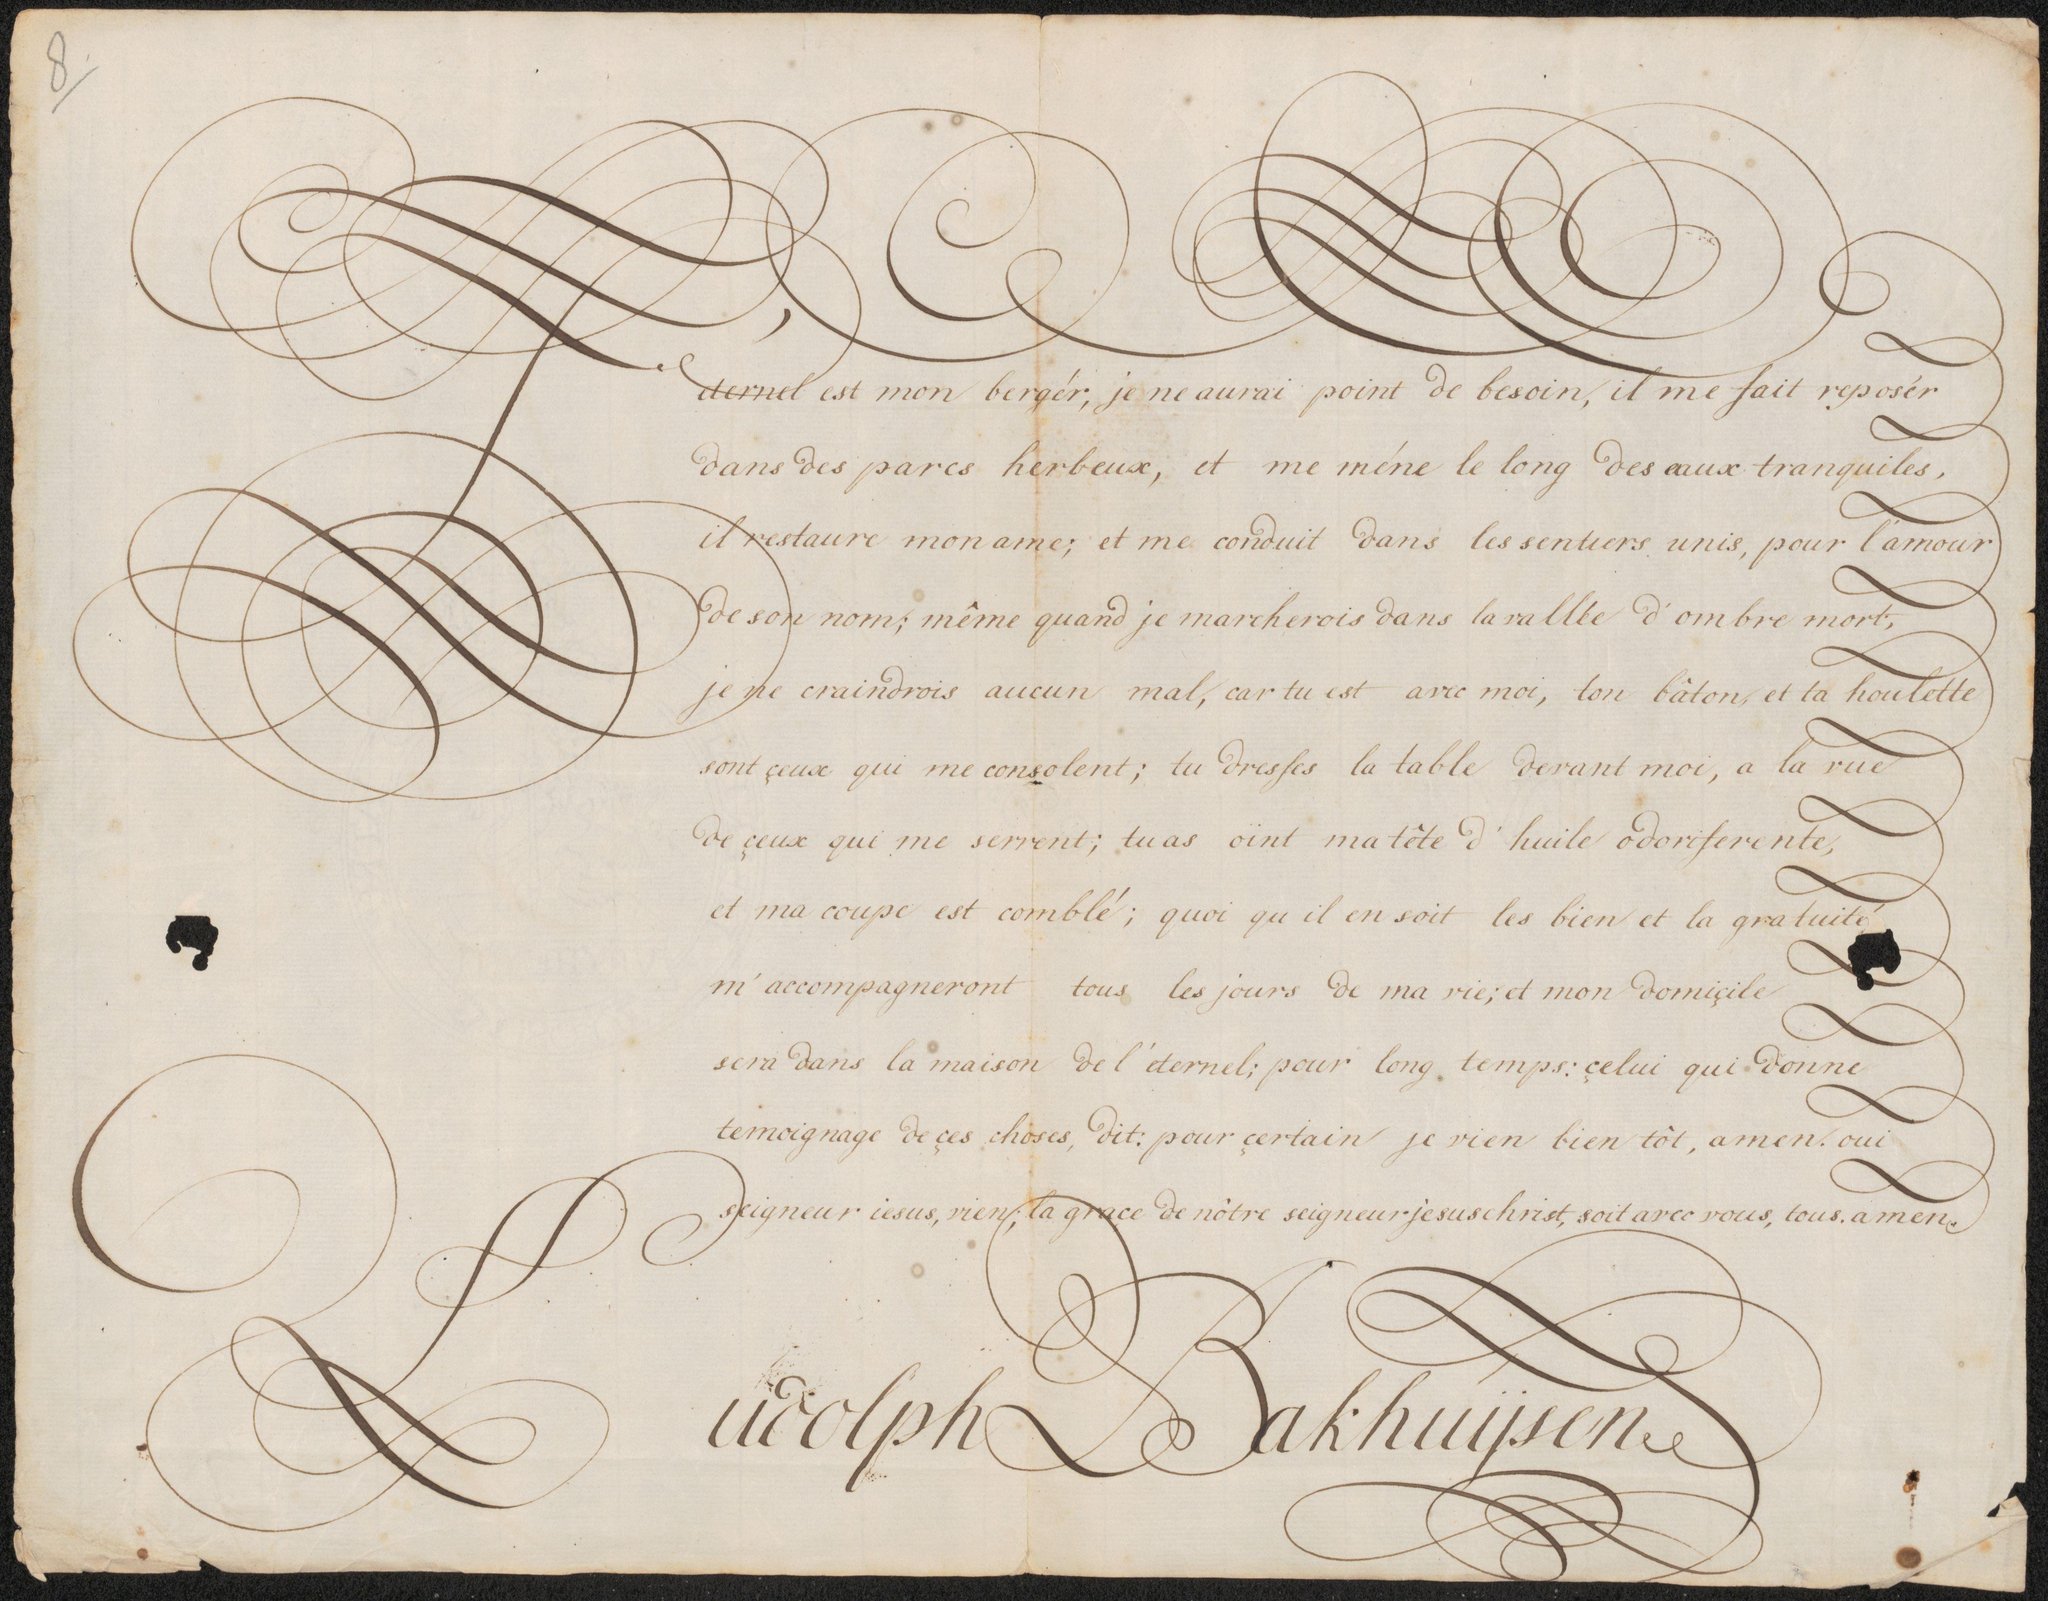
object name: manuscript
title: Proef van kalligrafie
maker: ludolf bakhuysen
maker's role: draughtsman, print maker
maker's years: 1631-1708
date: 1641-1708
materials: ink, paper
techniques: pen, writing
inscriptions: collector's mark: Lugt 2233, watermark